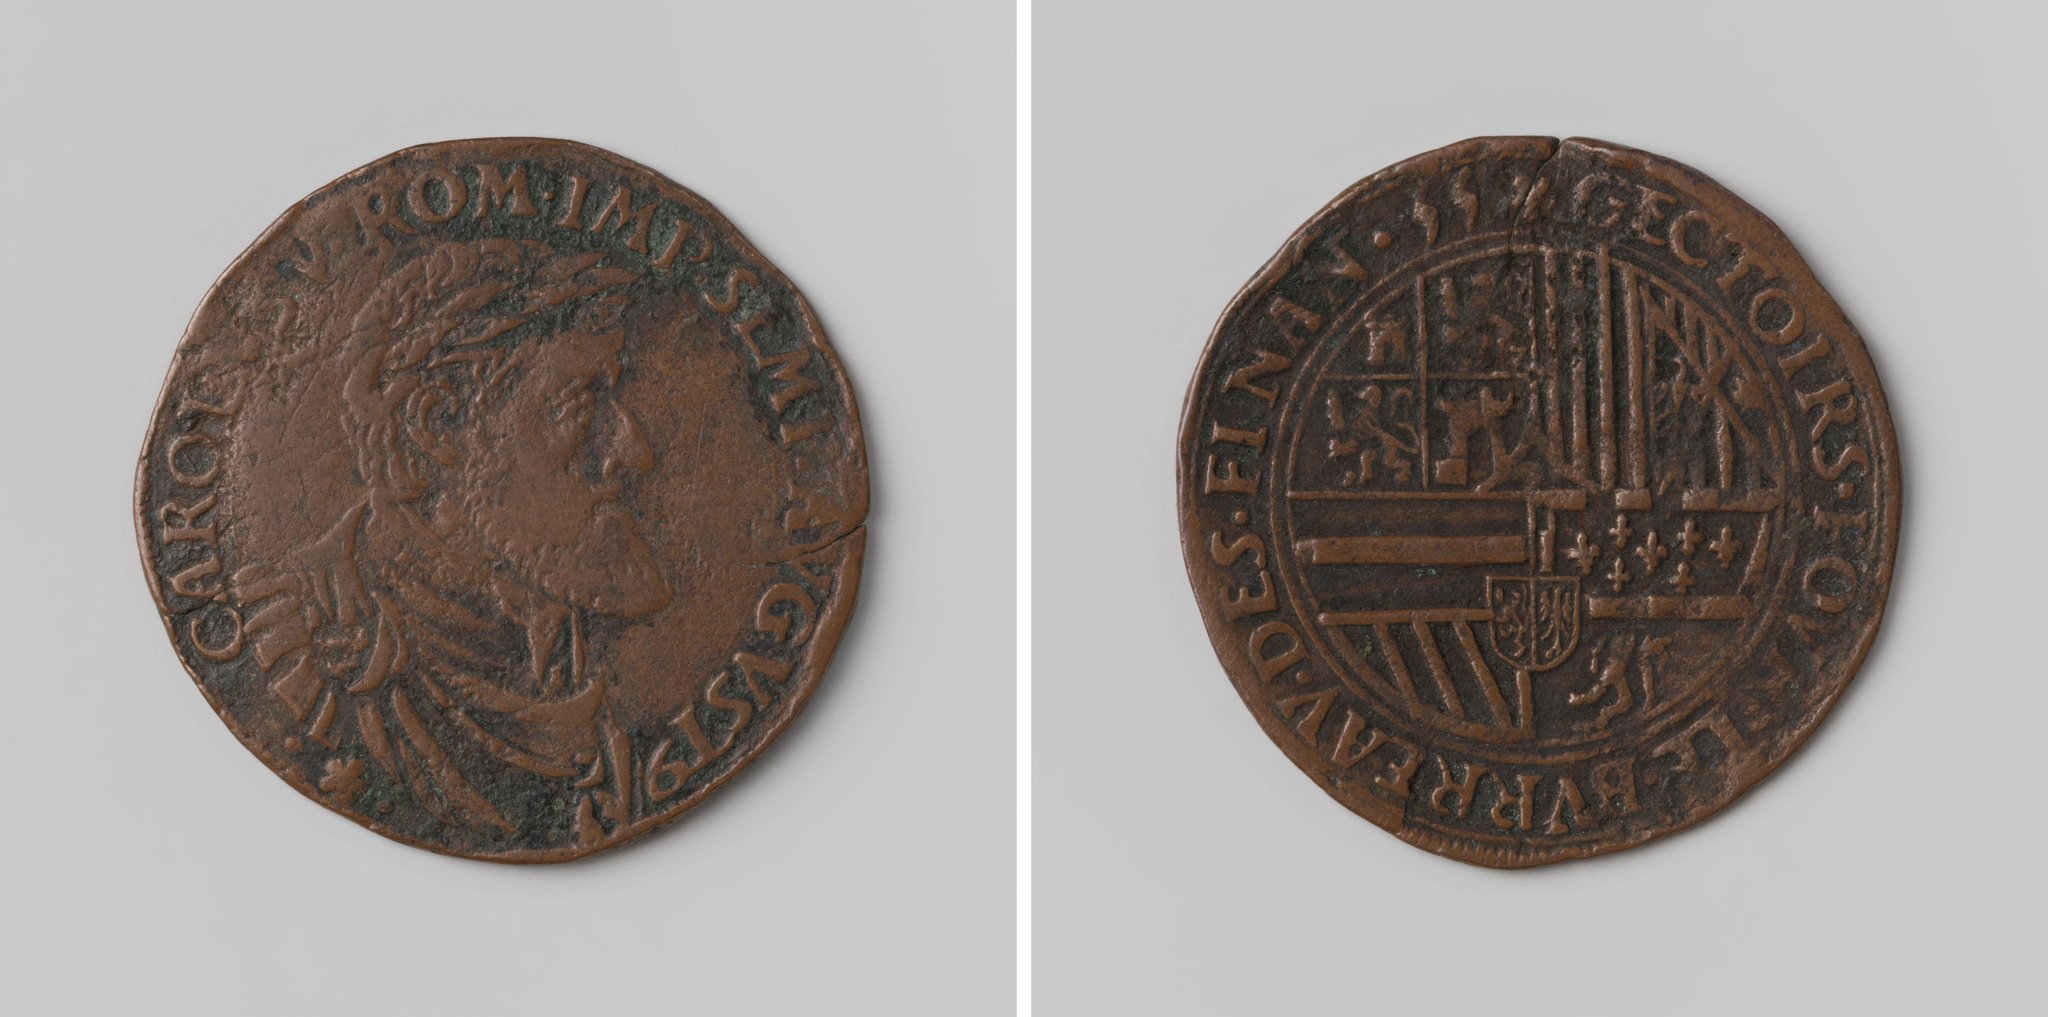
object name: jeton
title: Karel V, Duits keizer, rekenpenning van de raad van Financiën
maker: Anonymous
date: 1555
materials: copper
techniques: striking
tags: ghent, charles v (holy roman emperor and king of spain)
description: Koperen penning. Voorzijde: borststuk man met lauwerkrans binnen omschrift. Keerzijde: wapenschild binnen omschrift